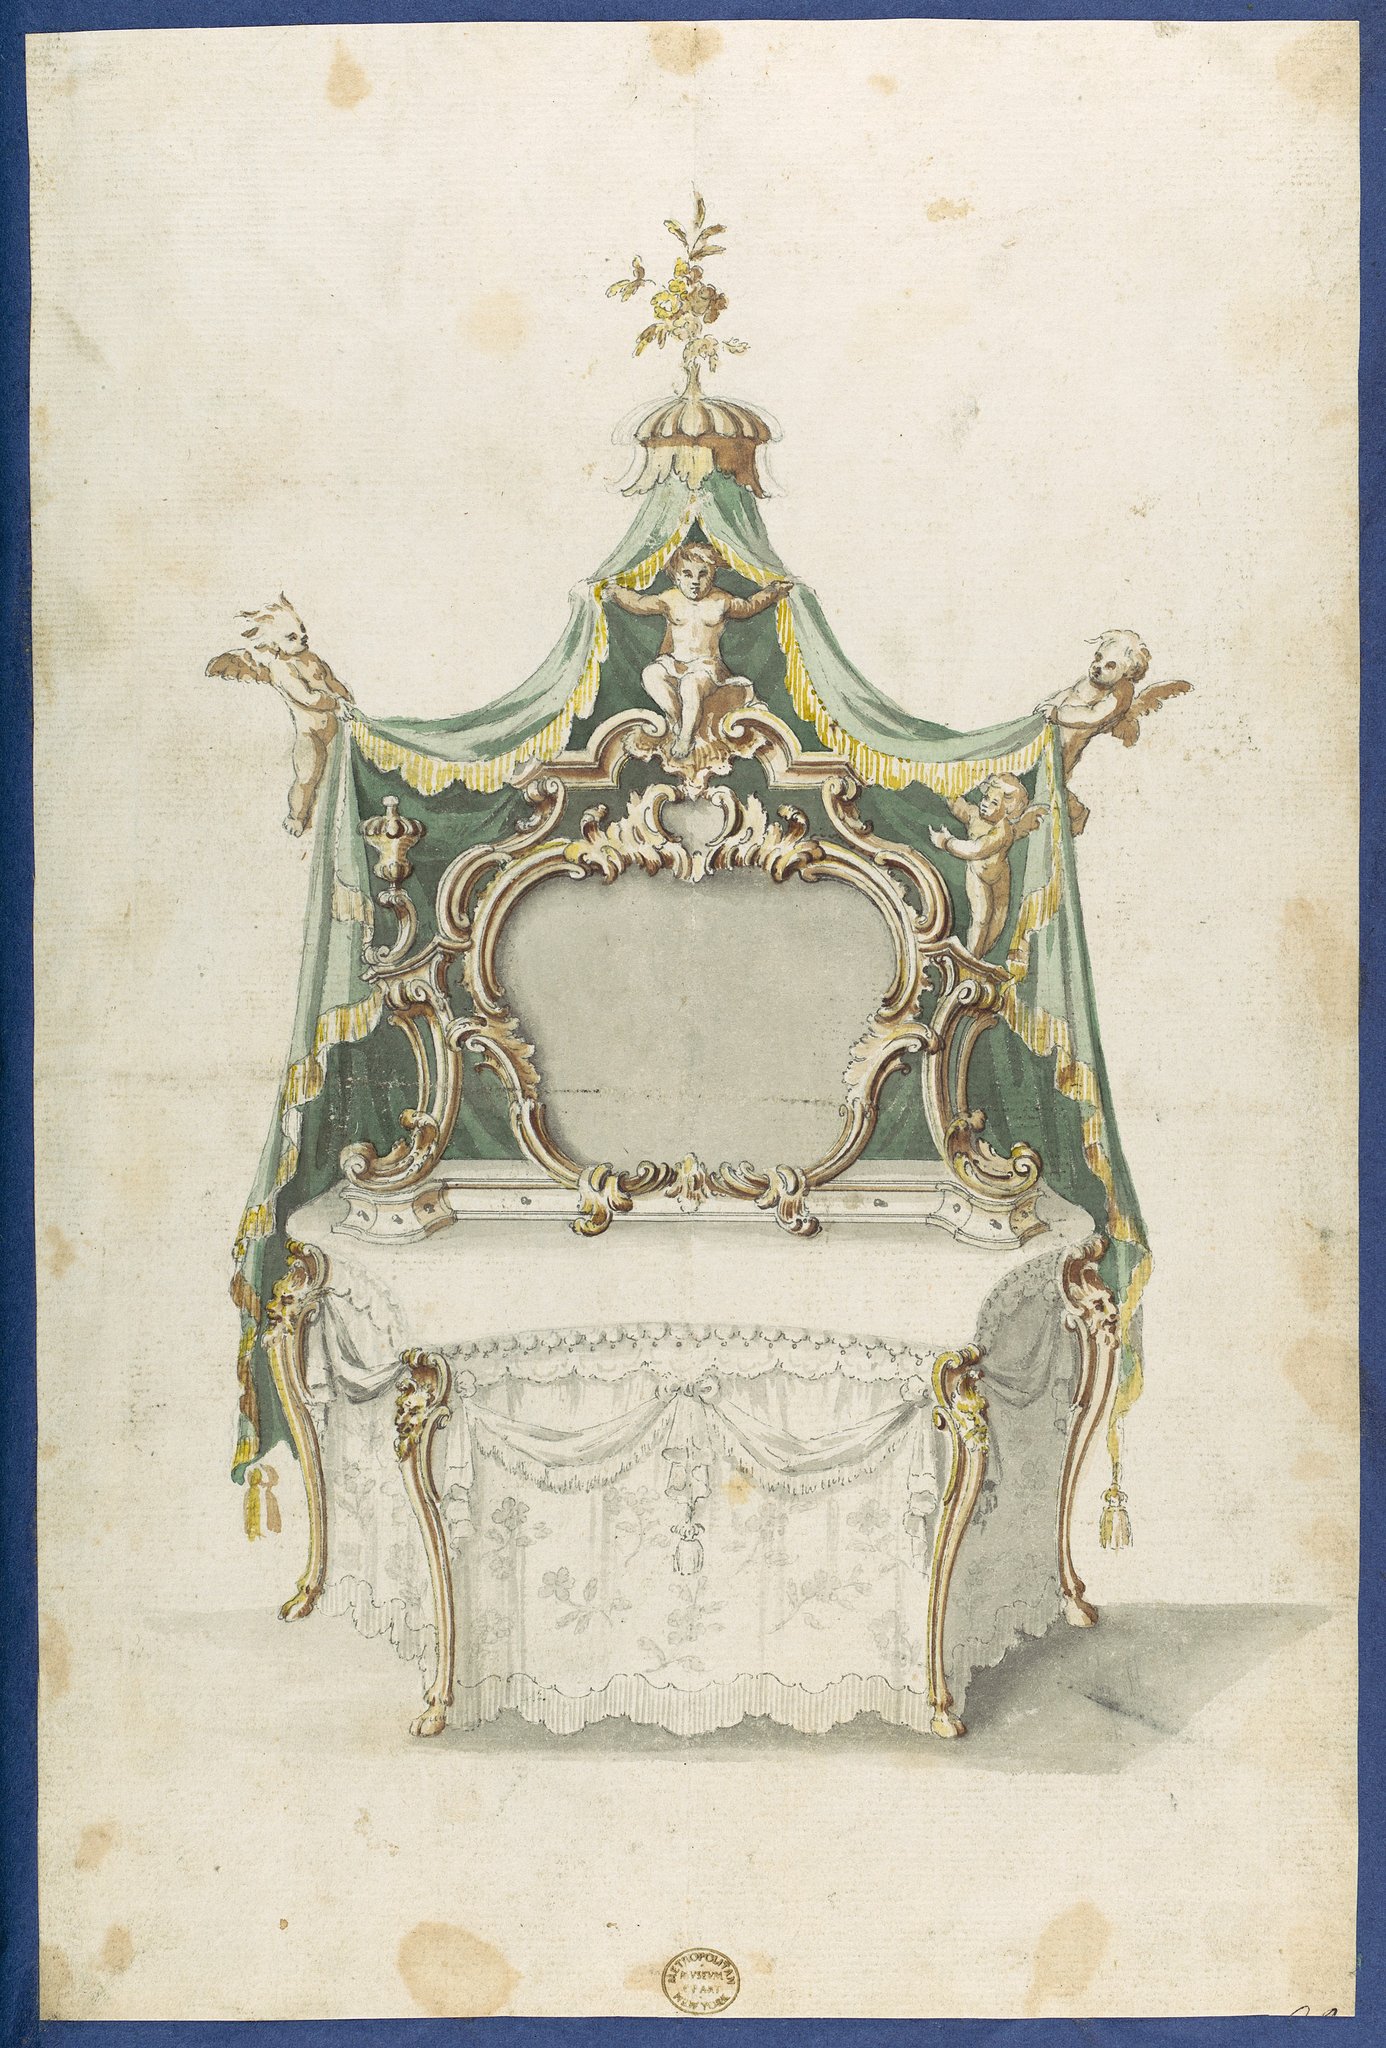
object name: drawing ornament architecture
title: Toilet Table, from Chippendale Drawings, Vol. II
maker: thomas chippendale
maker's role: artist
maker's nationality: british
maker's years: 1718-1779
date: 1760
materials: ink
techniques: wash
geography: london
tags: tables,mirrors